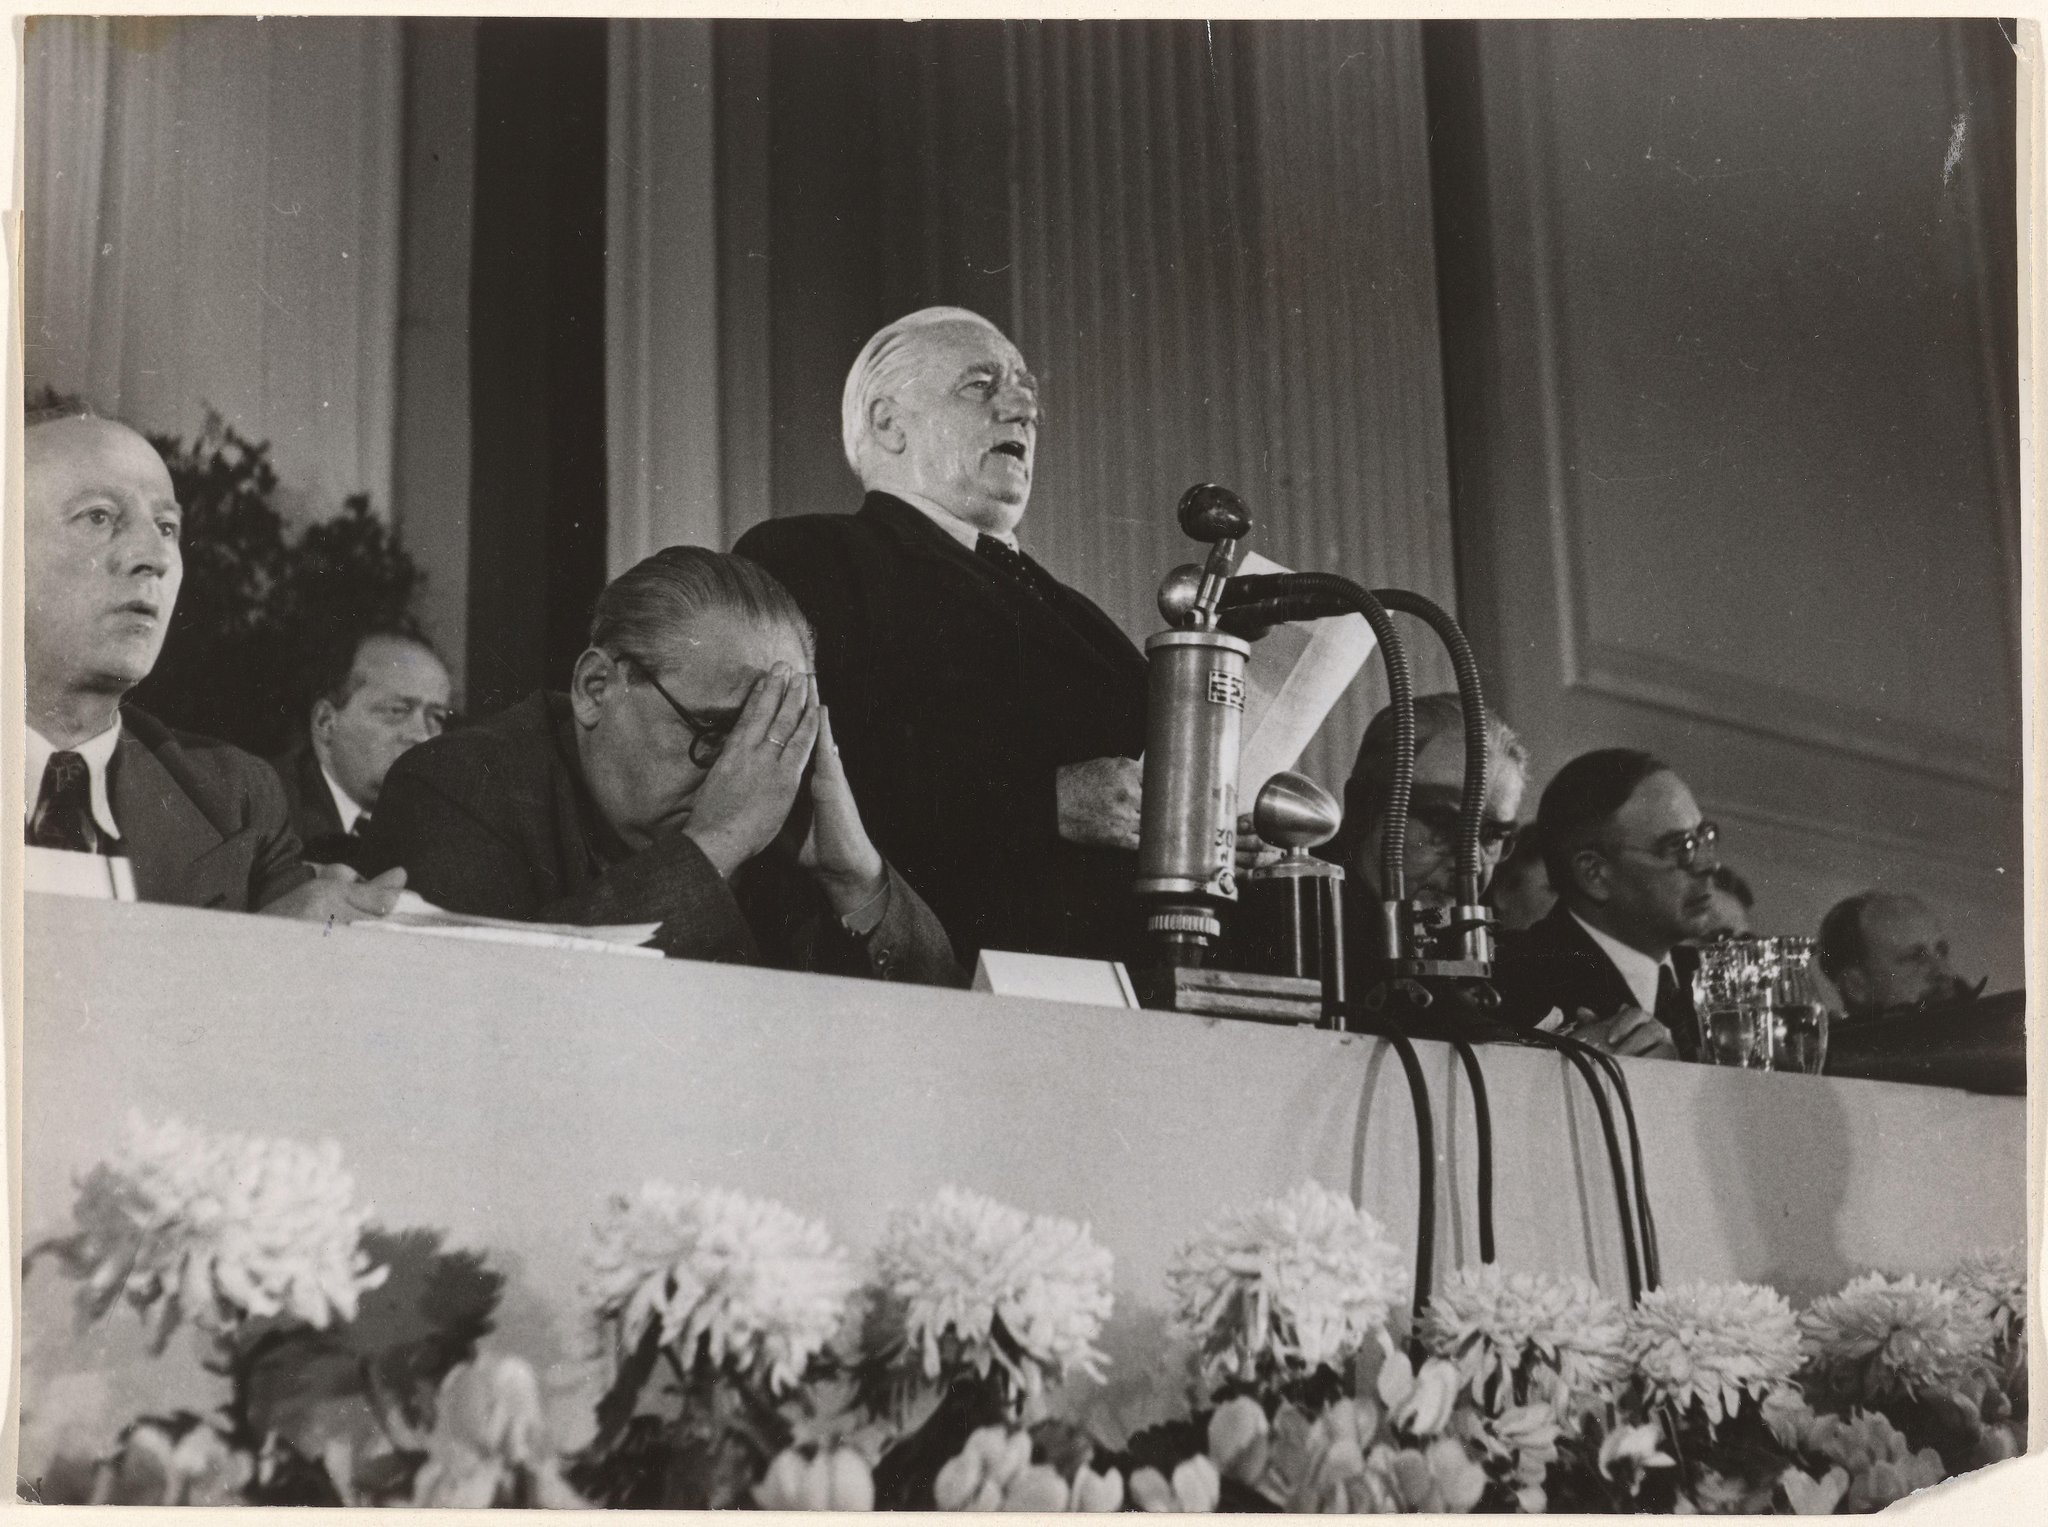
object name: photograph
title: An East German Republic established governement to be formed next week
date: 1949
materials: photographic support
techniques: gelatin silver print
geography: london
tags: berlin, politician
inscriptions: stamp: ‘Keystone press agency LTD’